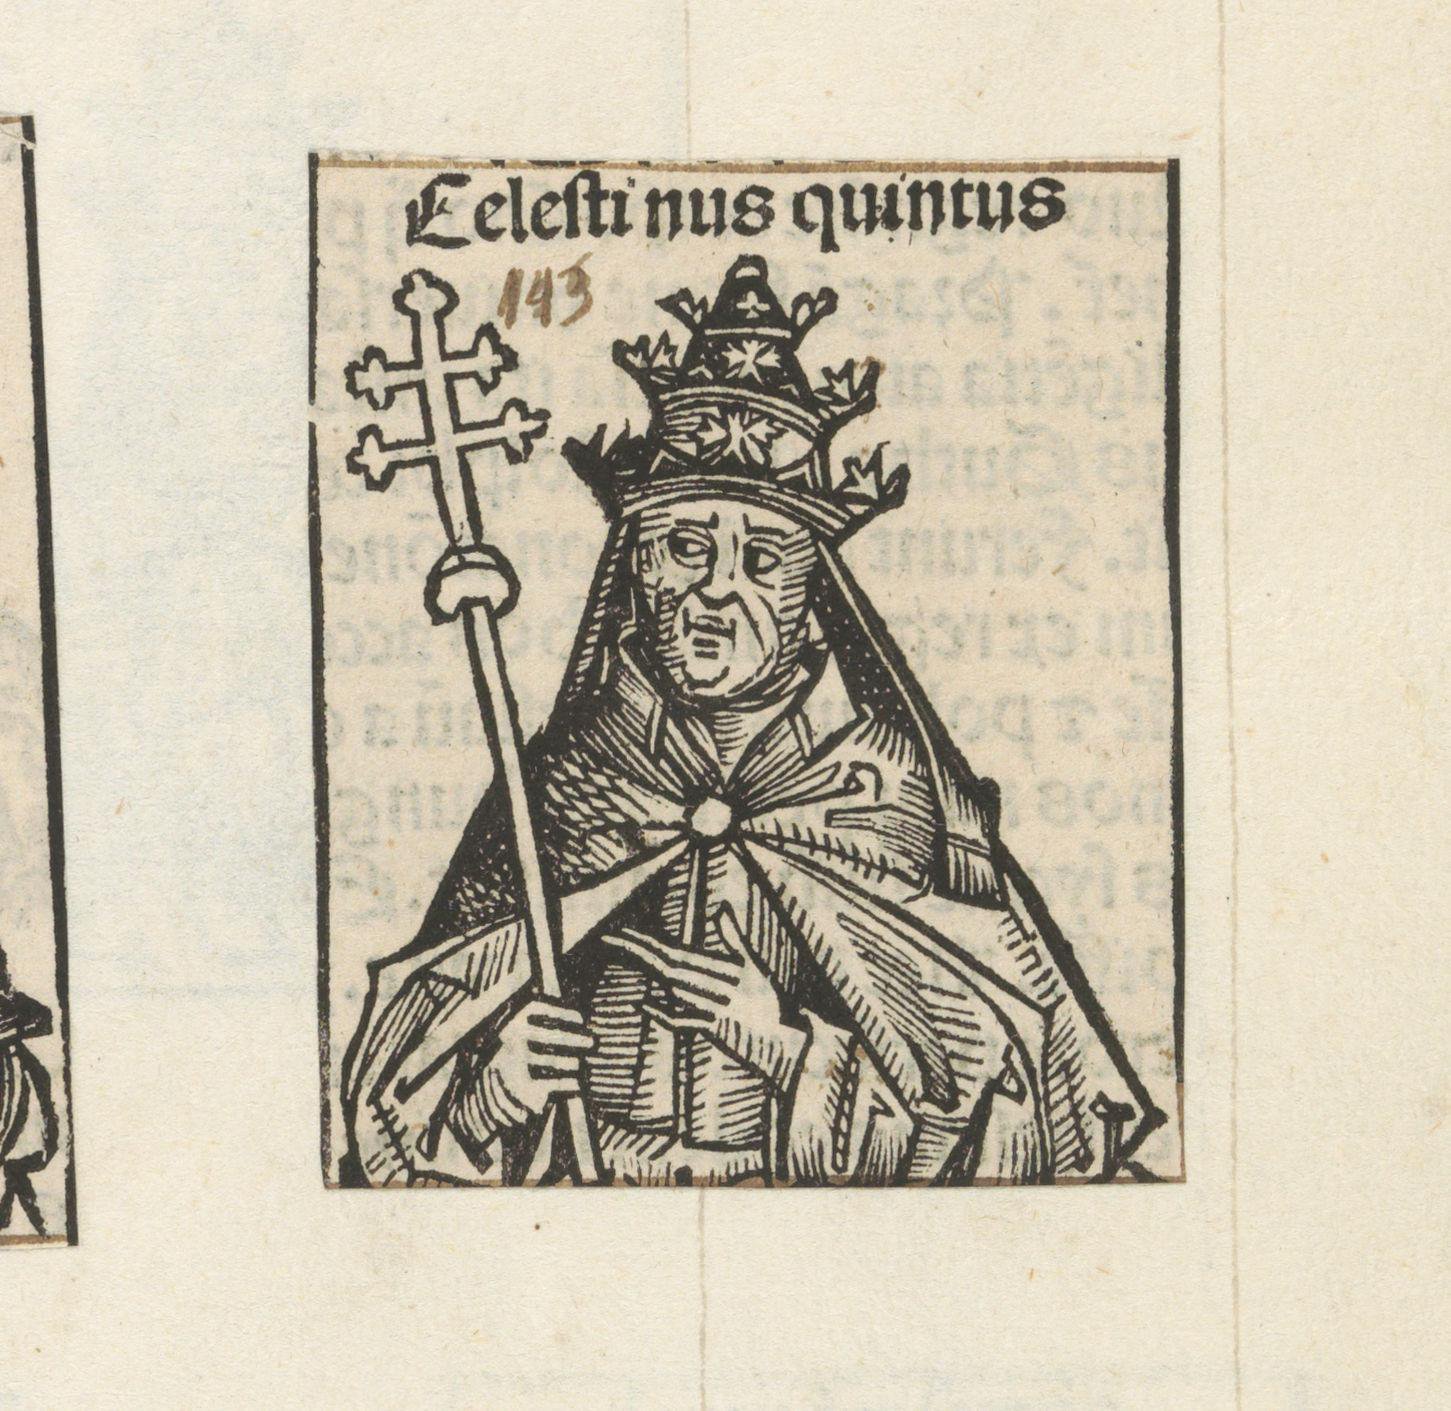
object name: book illustration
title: Liber Chronicarum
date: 1493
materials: paper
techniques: letterpress printing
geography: nuremberg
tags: pope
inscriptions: inscription: ‘143’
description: Een bloemkelk met een paus. Hij draagt een tiara en heeft een staf met dubbel kruis in zijn handen. De voorstelling is onderdeel van de opeenvolging pausen in de Liber Chronicarum. De tekst identificeert de man als Celestinus V. De prent maakt deel uit van een album.